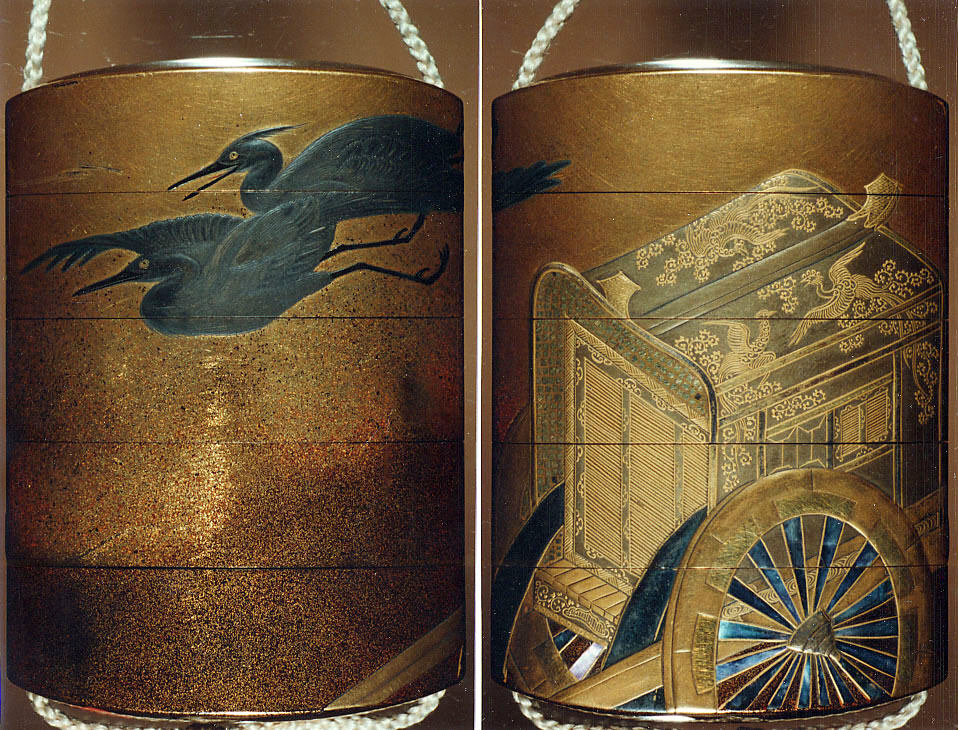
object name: inrō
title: Case (Inrō) with Design of Imperial Cart and Flying Herons (obverse); Court Carriage and Flying Herons (reverse)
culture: japanese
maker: kajikawa school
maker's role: artist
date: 1801-1900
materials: stone, gold, lacquer, metal, mother of pearl, silver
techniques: inlay, maki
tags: birds,carts